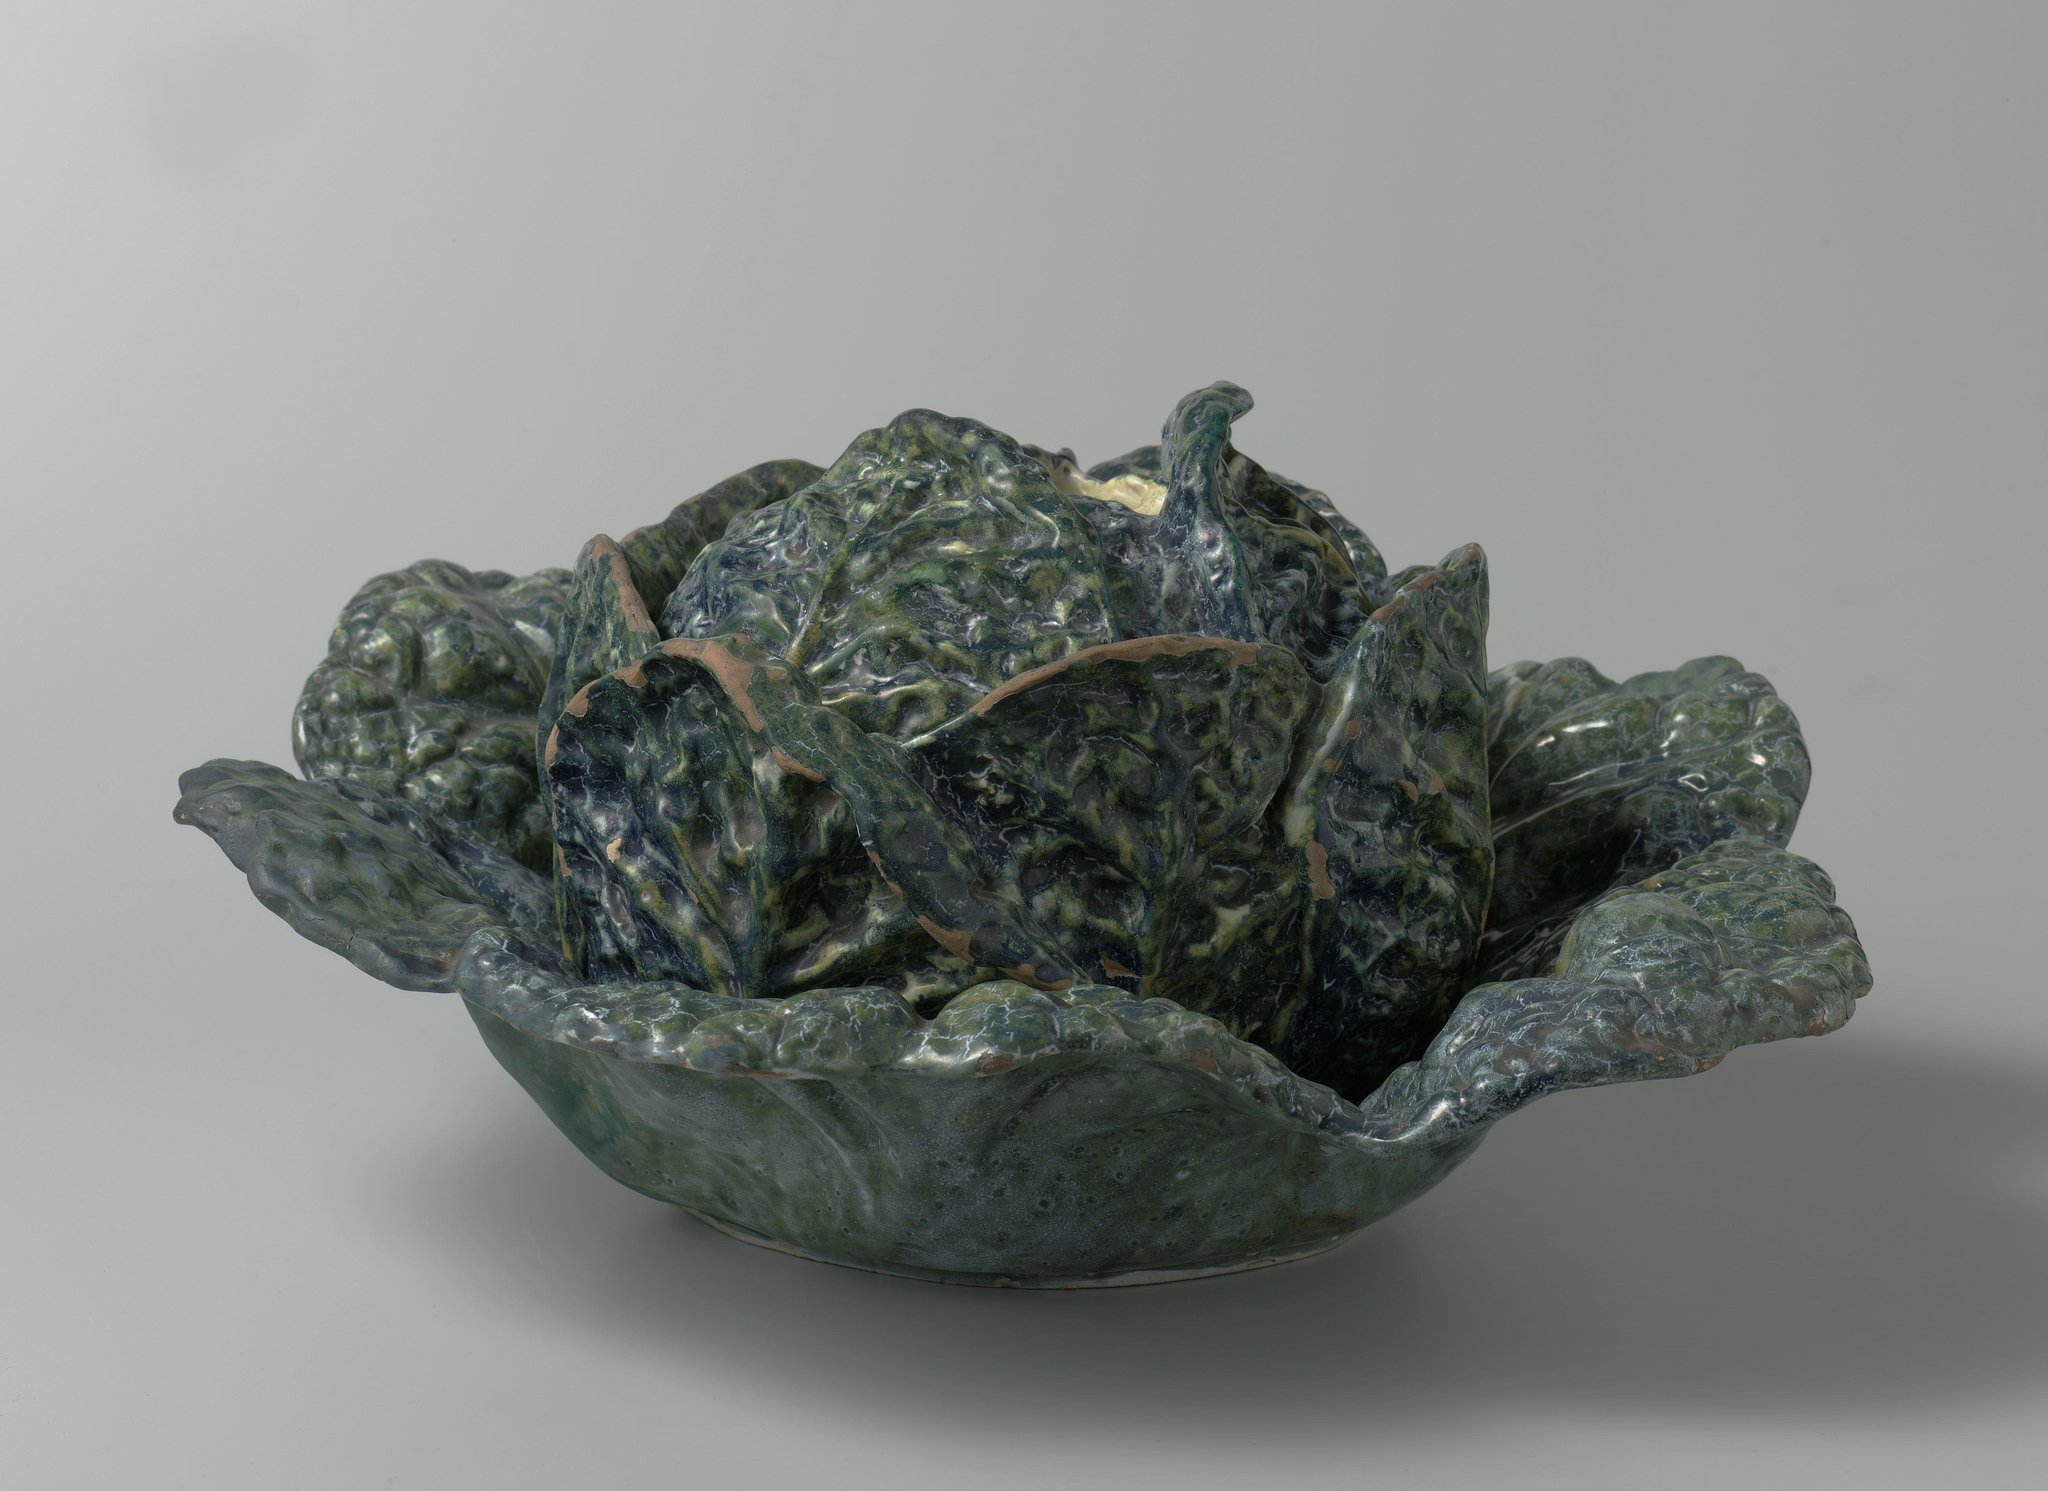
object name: soup tureen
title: Deksel van kom van soepterrine in de vorm van een groene kool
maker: Anonymous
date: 1750-1780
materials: earthenware, glaze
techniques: painted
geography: brussels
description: Soepterrine in de vorm van een groene kool, van groen beschilderde faience.